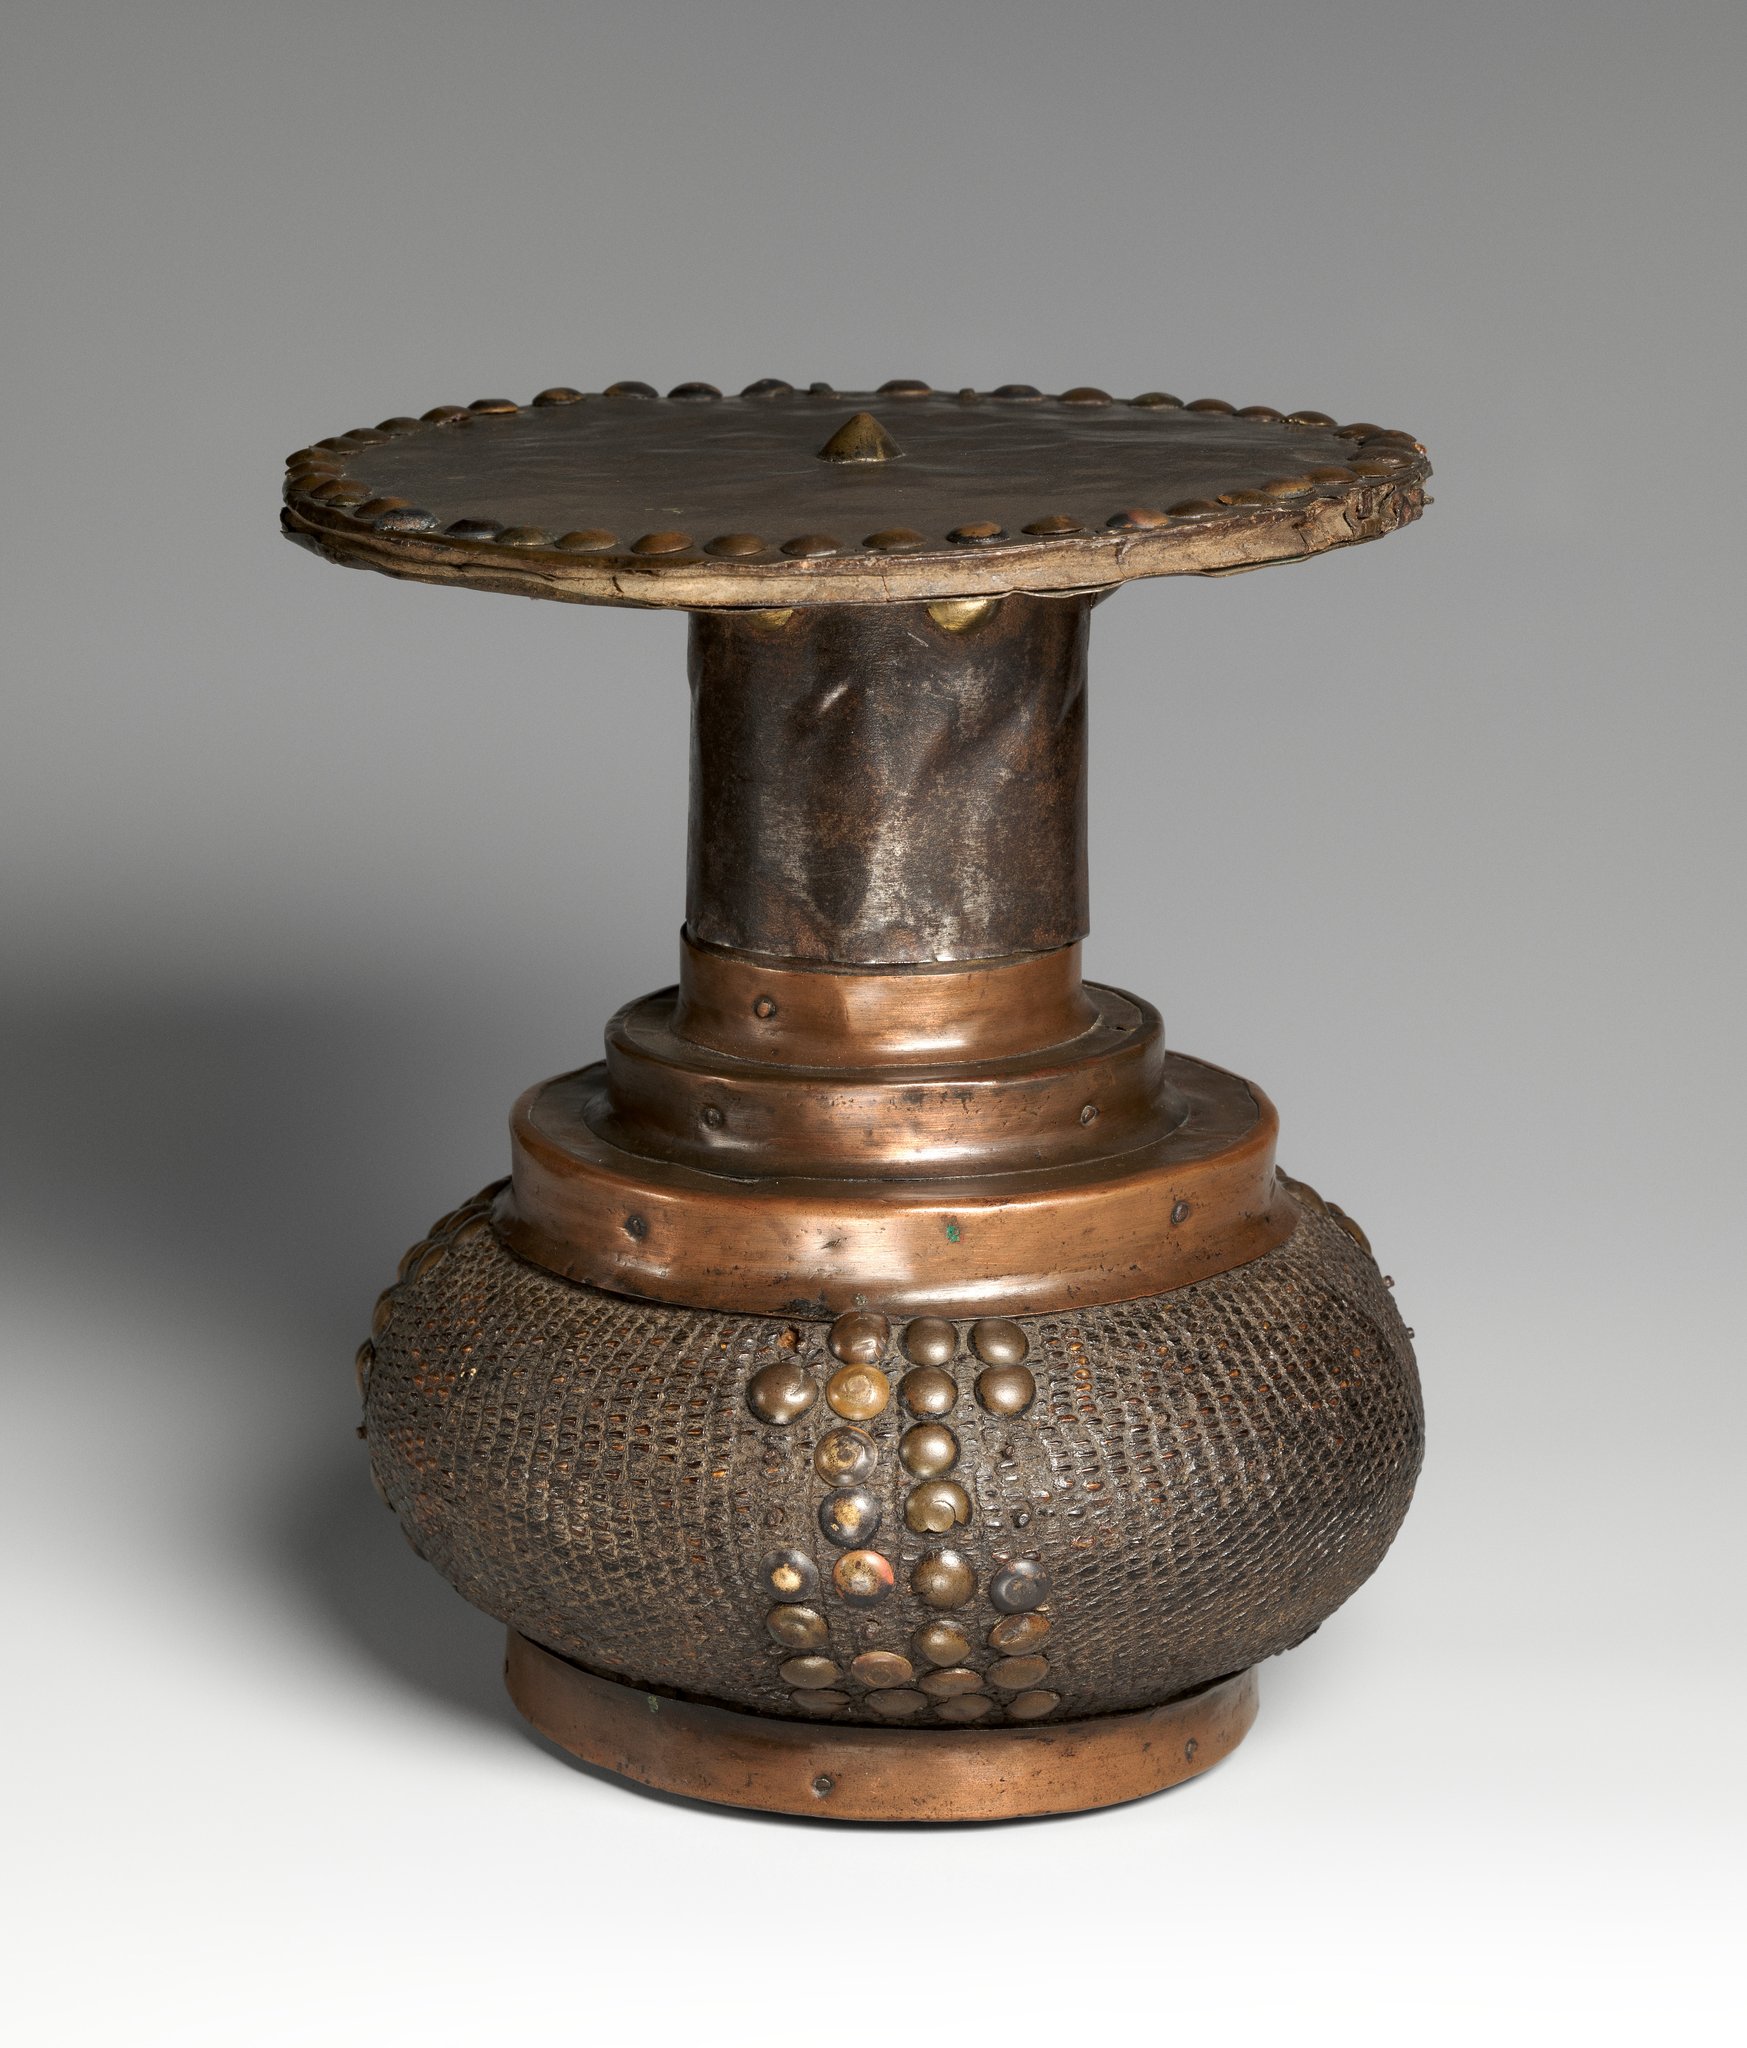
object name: vessel with lid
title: Lidded Gunpowder Container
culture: fang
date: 1878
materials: copper, skin, wood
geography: gabon